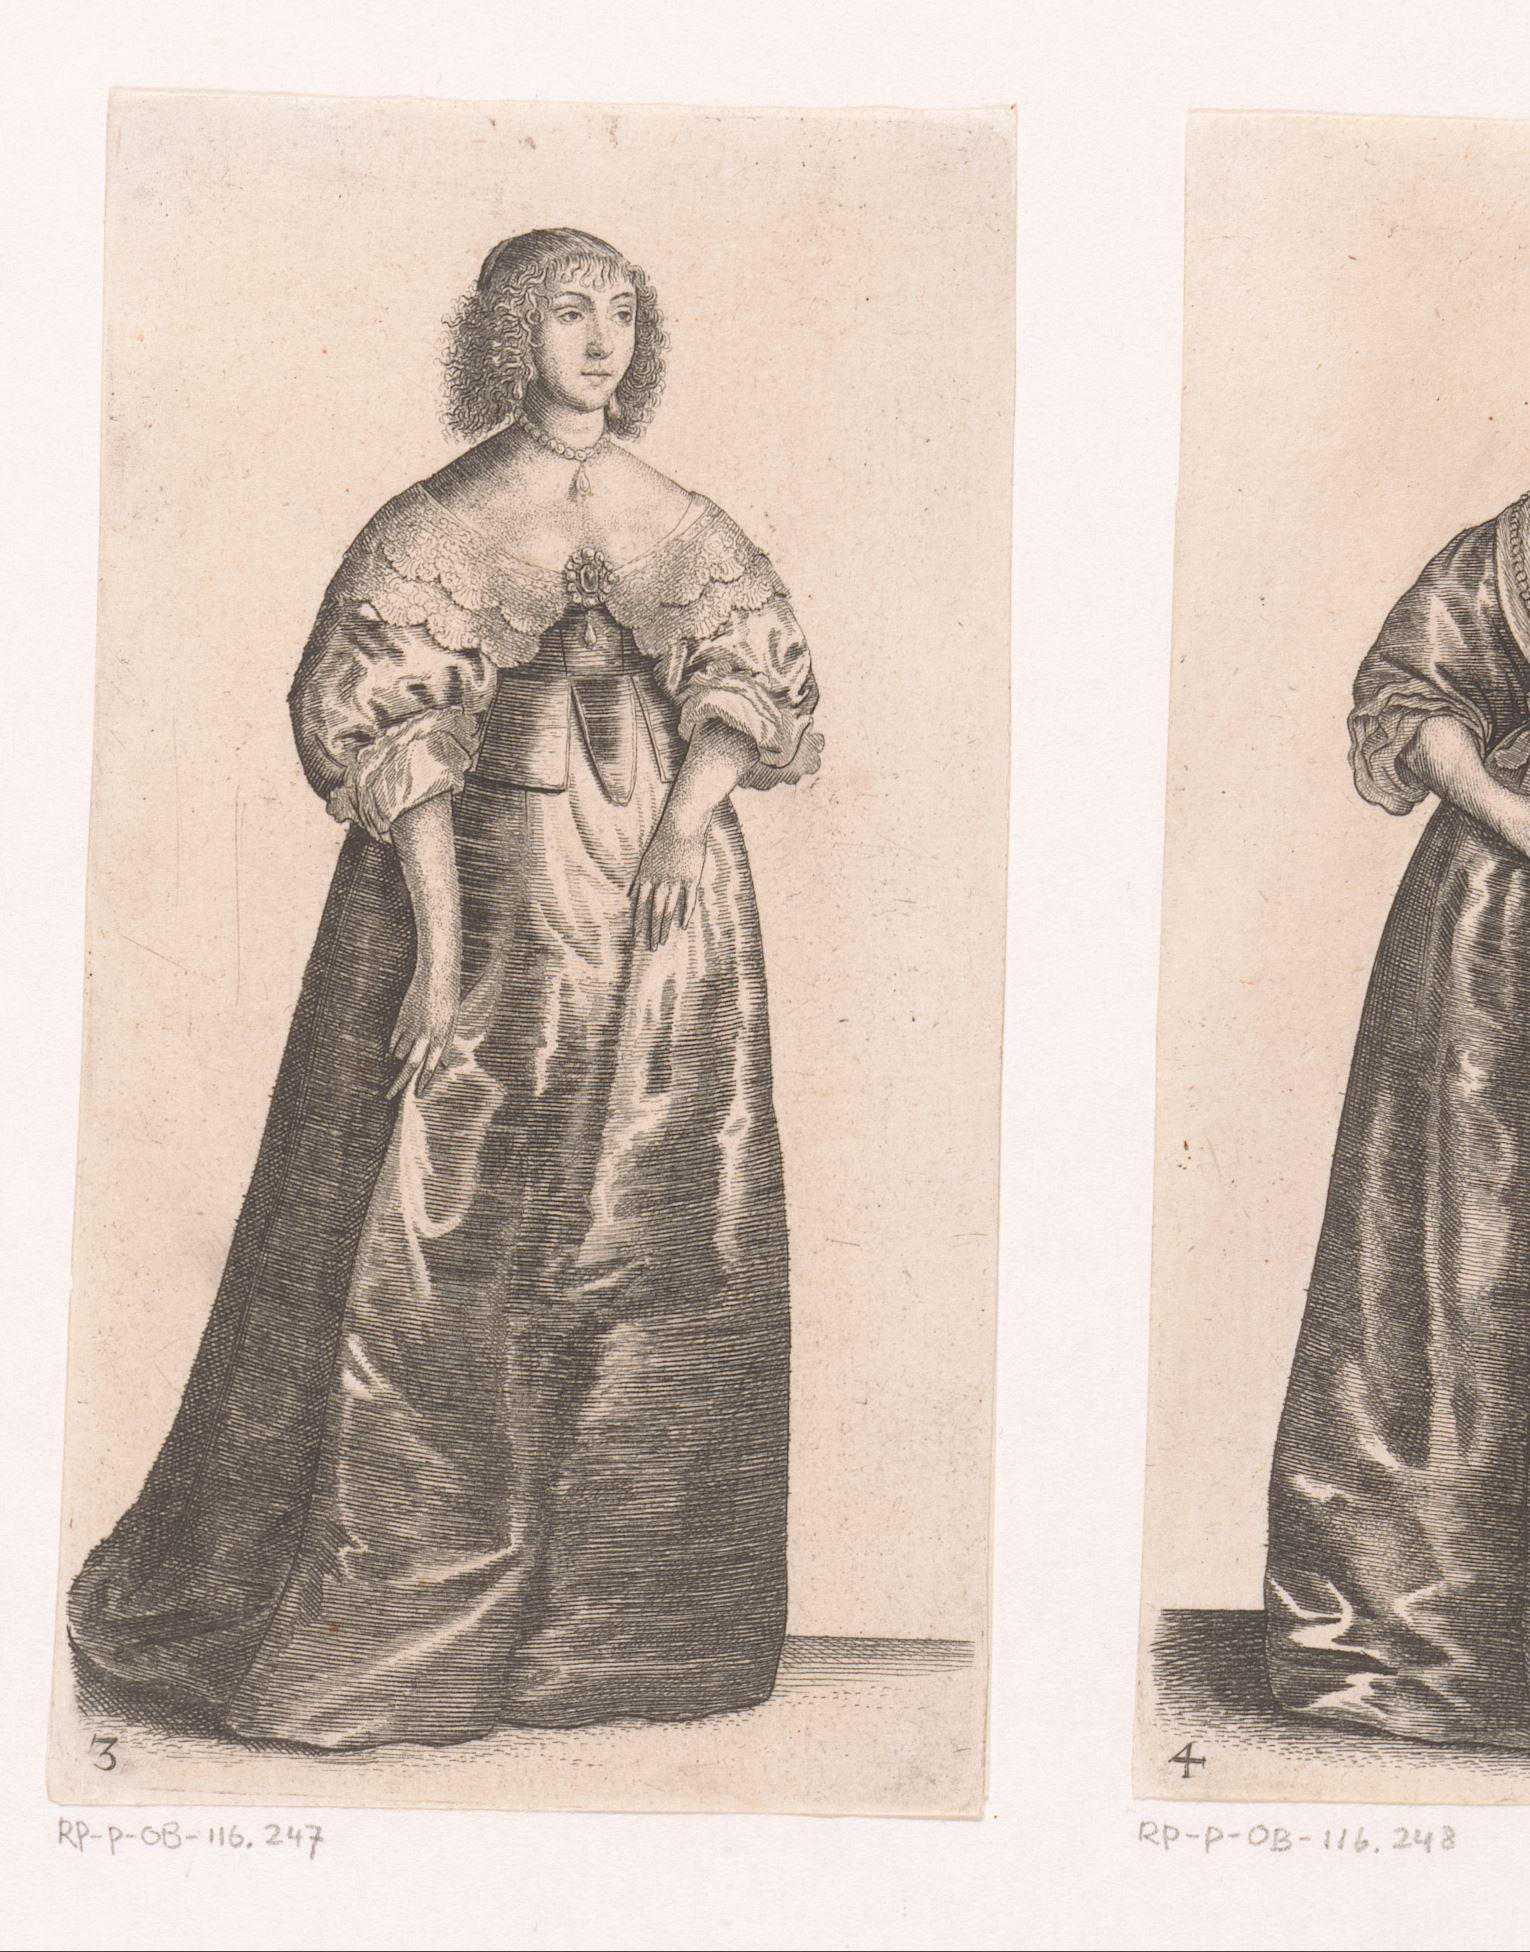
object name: costume print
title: Engelse vrouw van stand met juweel op de borst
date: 1638-1640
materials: paper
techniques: etching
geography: london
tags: ear-rings (+ women's clothes), brooch, agraffe, clasp (+ women's clothes), europeans: englishmen (+ women), styles of hairdress - aa - ~ women, fashion, clothing (+ lace used for clothes), fashion plates, clothes, costume (+ women's clothes), dress, gown (+ women's clothes), pearl; pearl necklace (+ women's clothes)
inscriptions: collector's mark: Lugt 2228, collector's mark: Lugt 2760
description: Engelse vrouw gekleed in japon met laag decolleté, afgezet met kant. Om haar hals een parelketting met hanger. Een groot juweel in het midden van de kanten boord van haar japon, bij het decolleté.